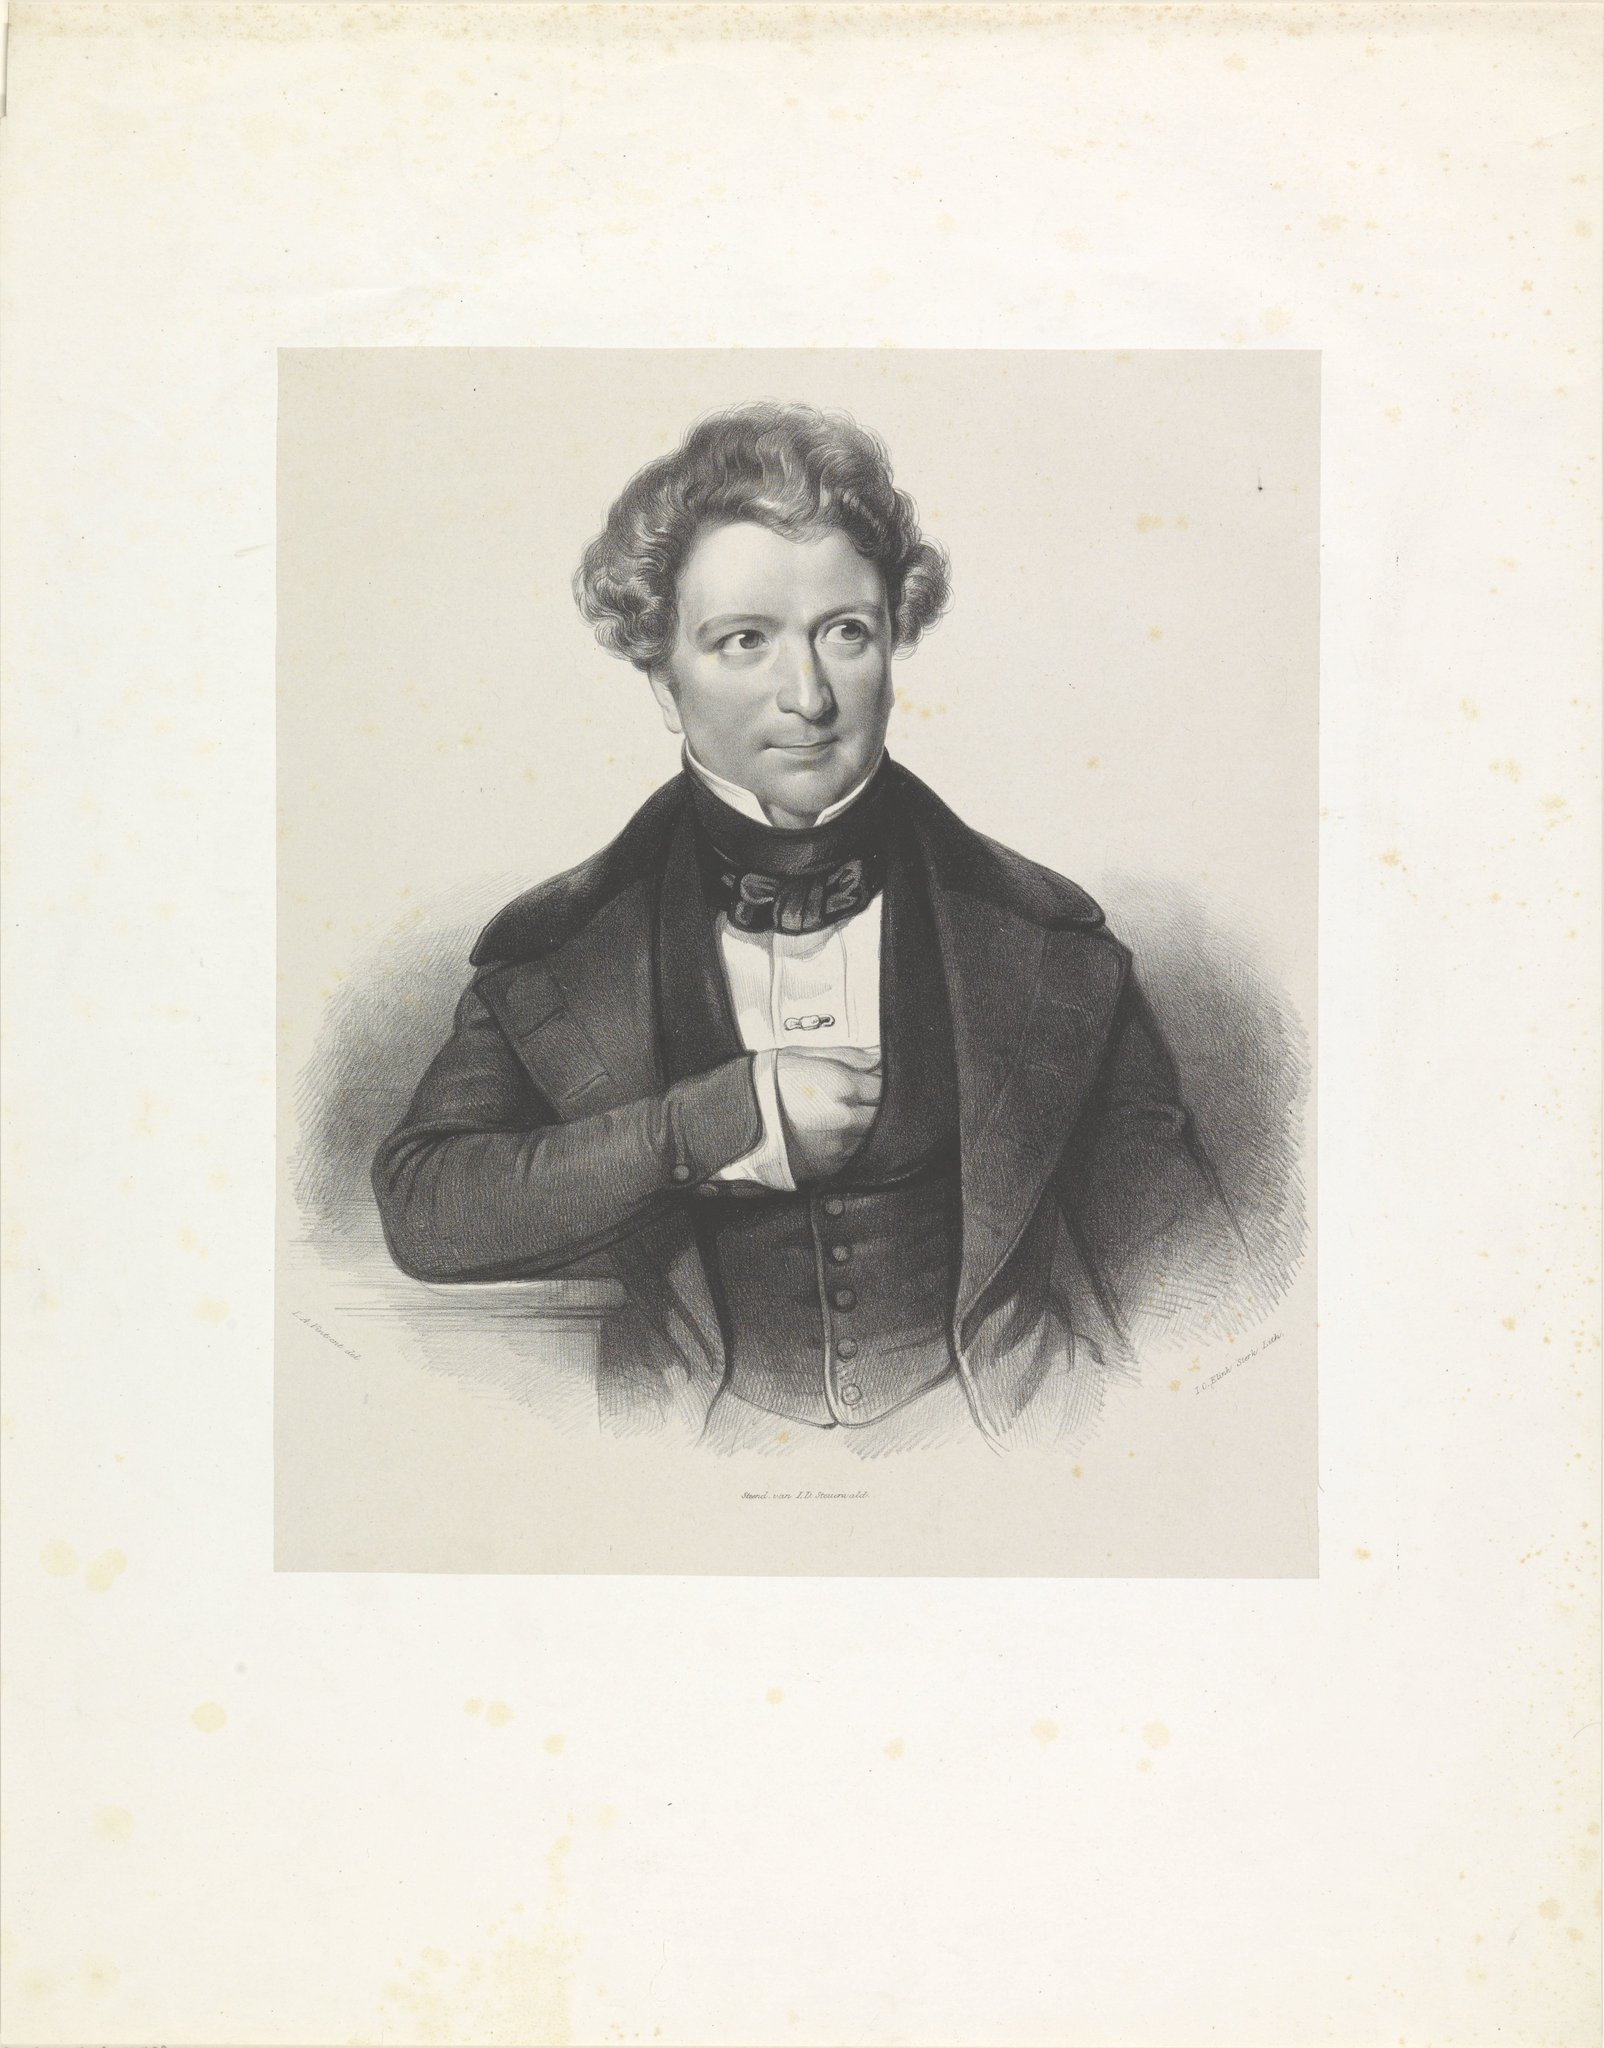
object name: print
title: Portret van een onbekende man met zijn hand in zijn vest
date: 1818-1863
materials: paper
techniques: lithograph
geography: the hague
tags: historical persons (+ (full) bust portrait)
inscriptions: collector's mark: Lugt 2228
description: De geportretteerde kijkt naar rechts. Met zijn rechterelleboog steunt hij op een verhoging.